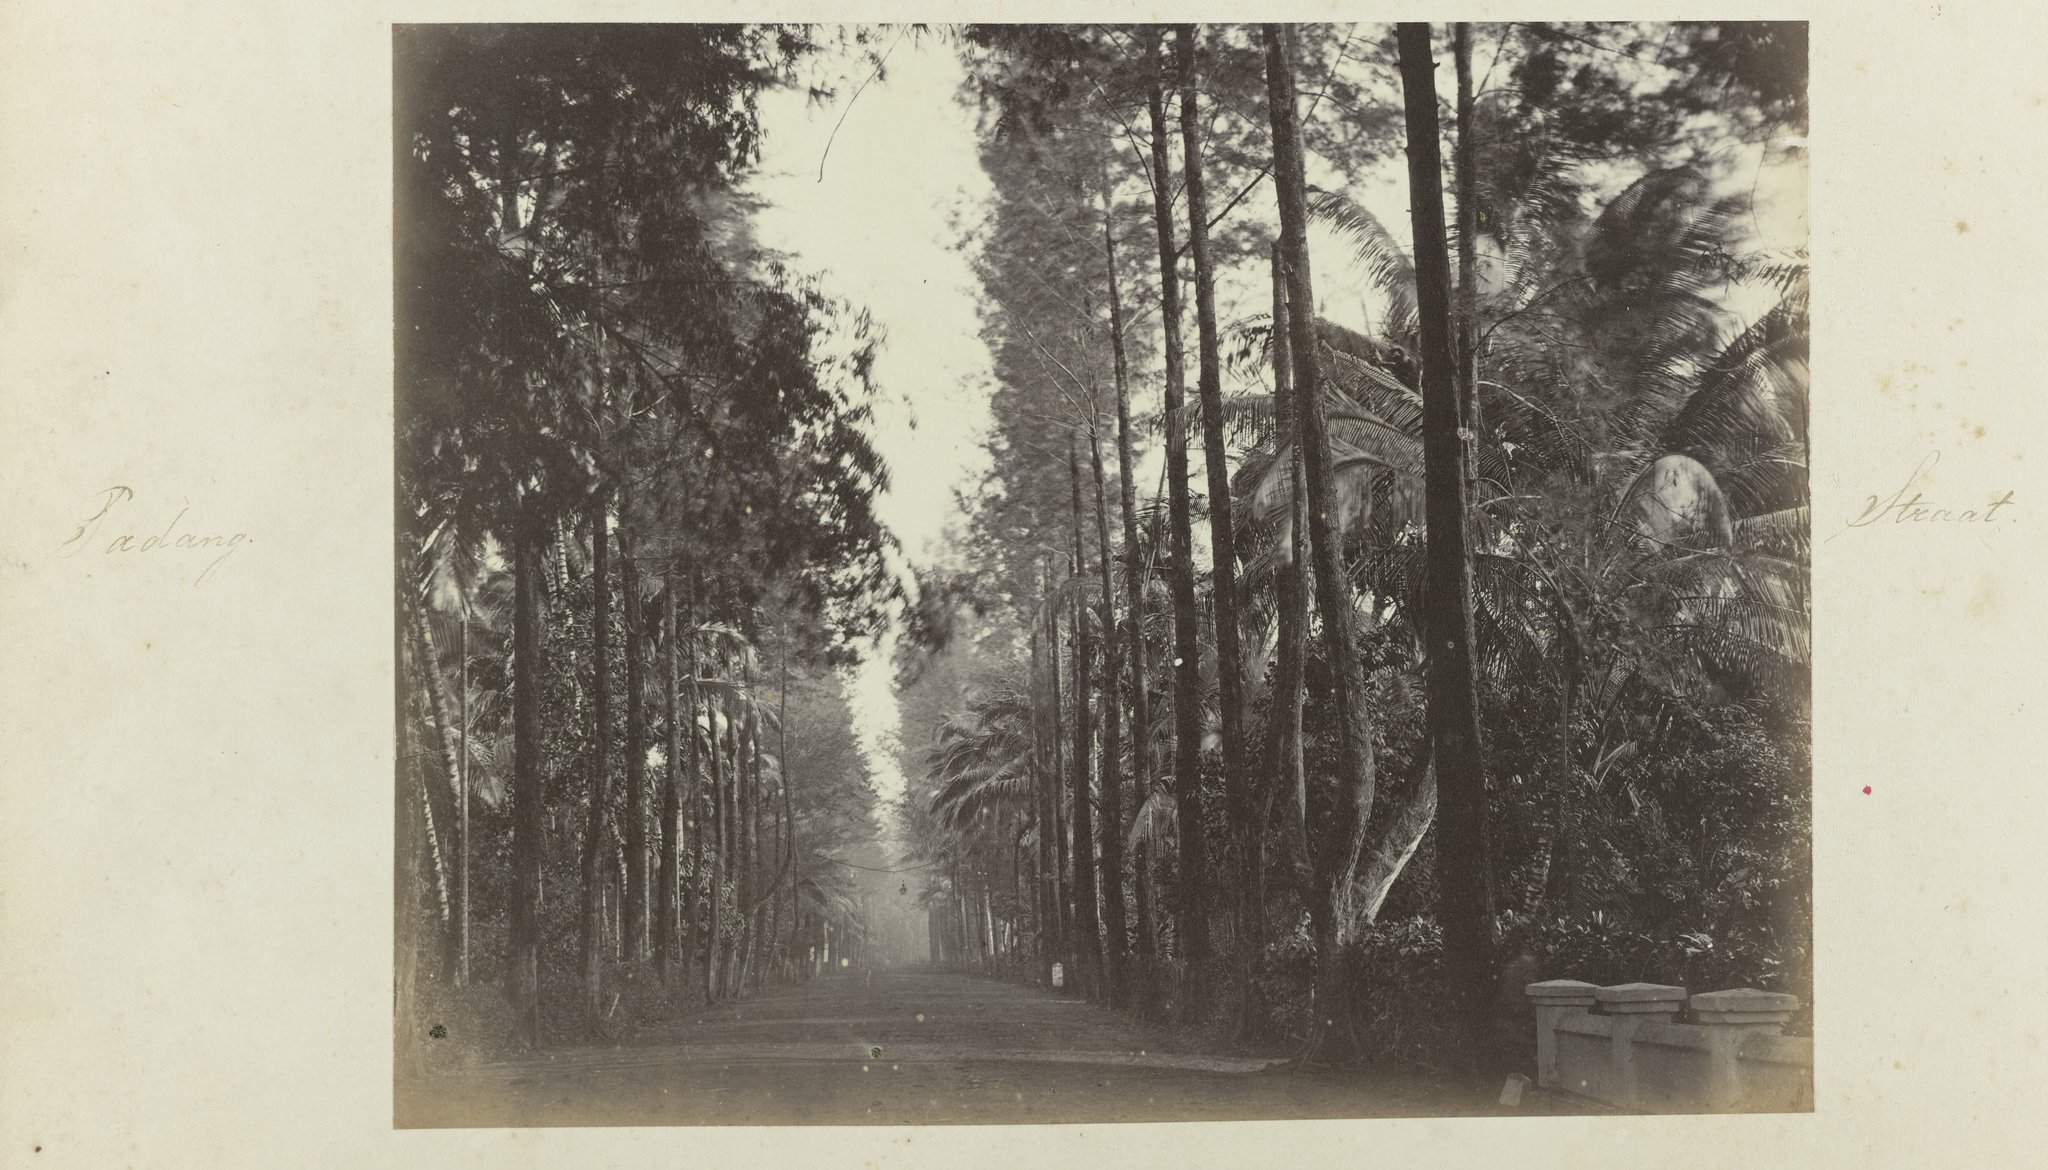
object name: photograph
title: Padang. Straat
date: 1863-1869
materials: photographic support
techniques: albumen print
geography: padang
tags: street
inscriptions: inscription: ‘Padang. Straat’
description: Gezicht in een straat te Padang, aan weerszijden bomen. Onderdeel van het groene fotoalbum met foto's van Java, uit het bezit van apotheker Specht-Grijp, die in 1865 vanuit Batavia naar Nederland terugkeerde.